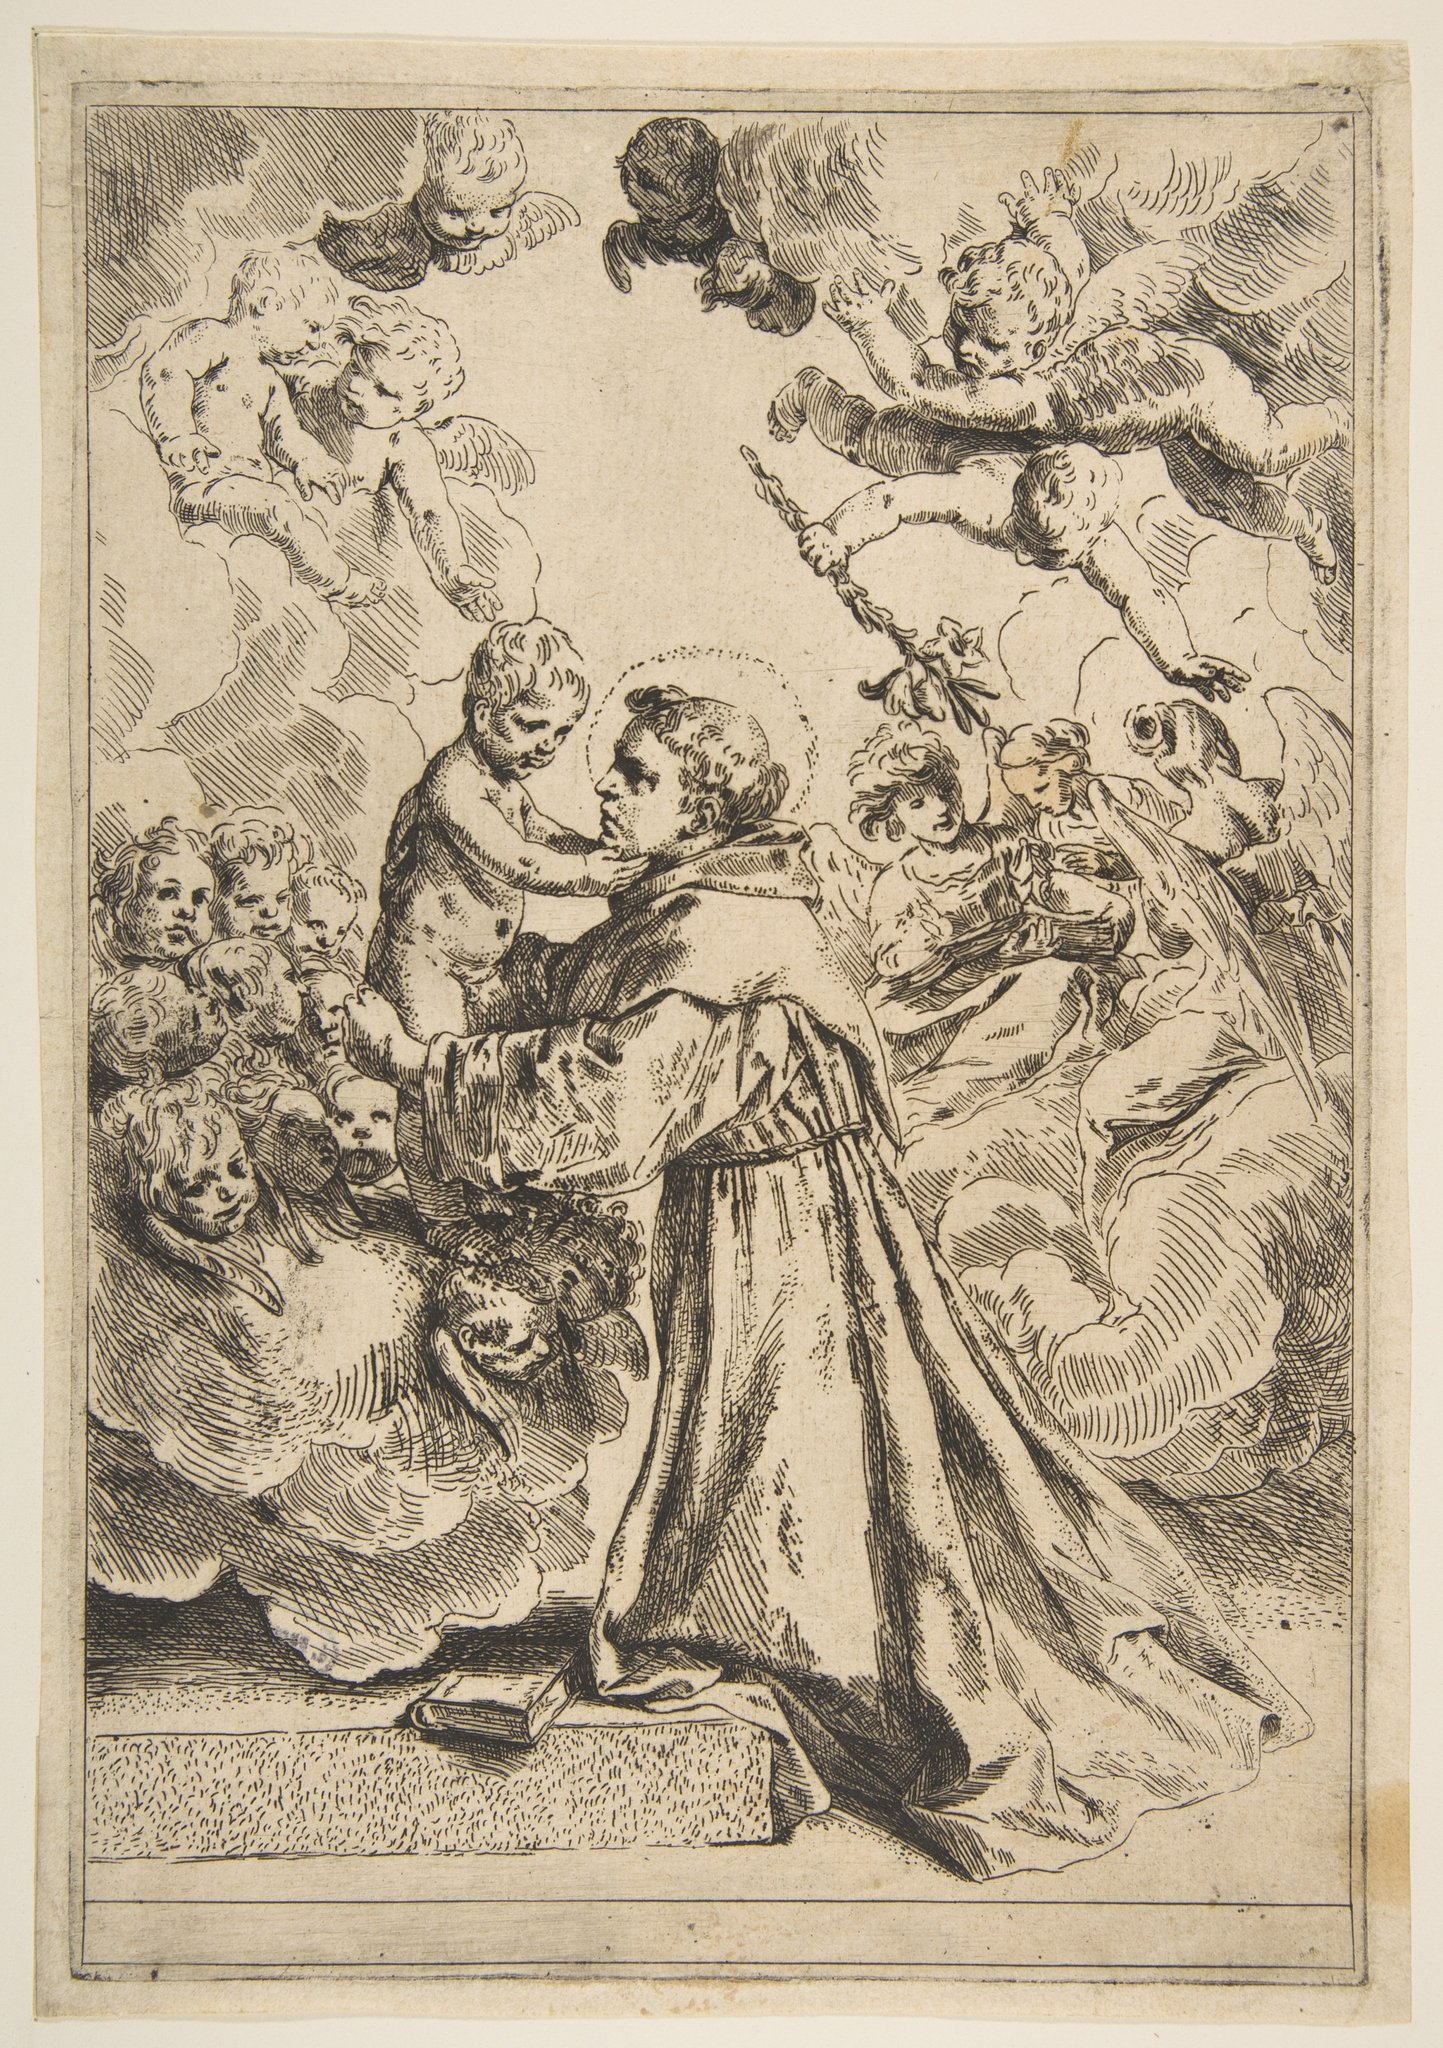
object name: print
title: Saint Anthony of Padua adoring the Christ Child in Glory, copy after Cantarini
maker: simone cantarini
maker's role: artist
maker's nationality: italian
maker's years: 1612-1648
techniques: etching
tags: angels,christ,saint anthony